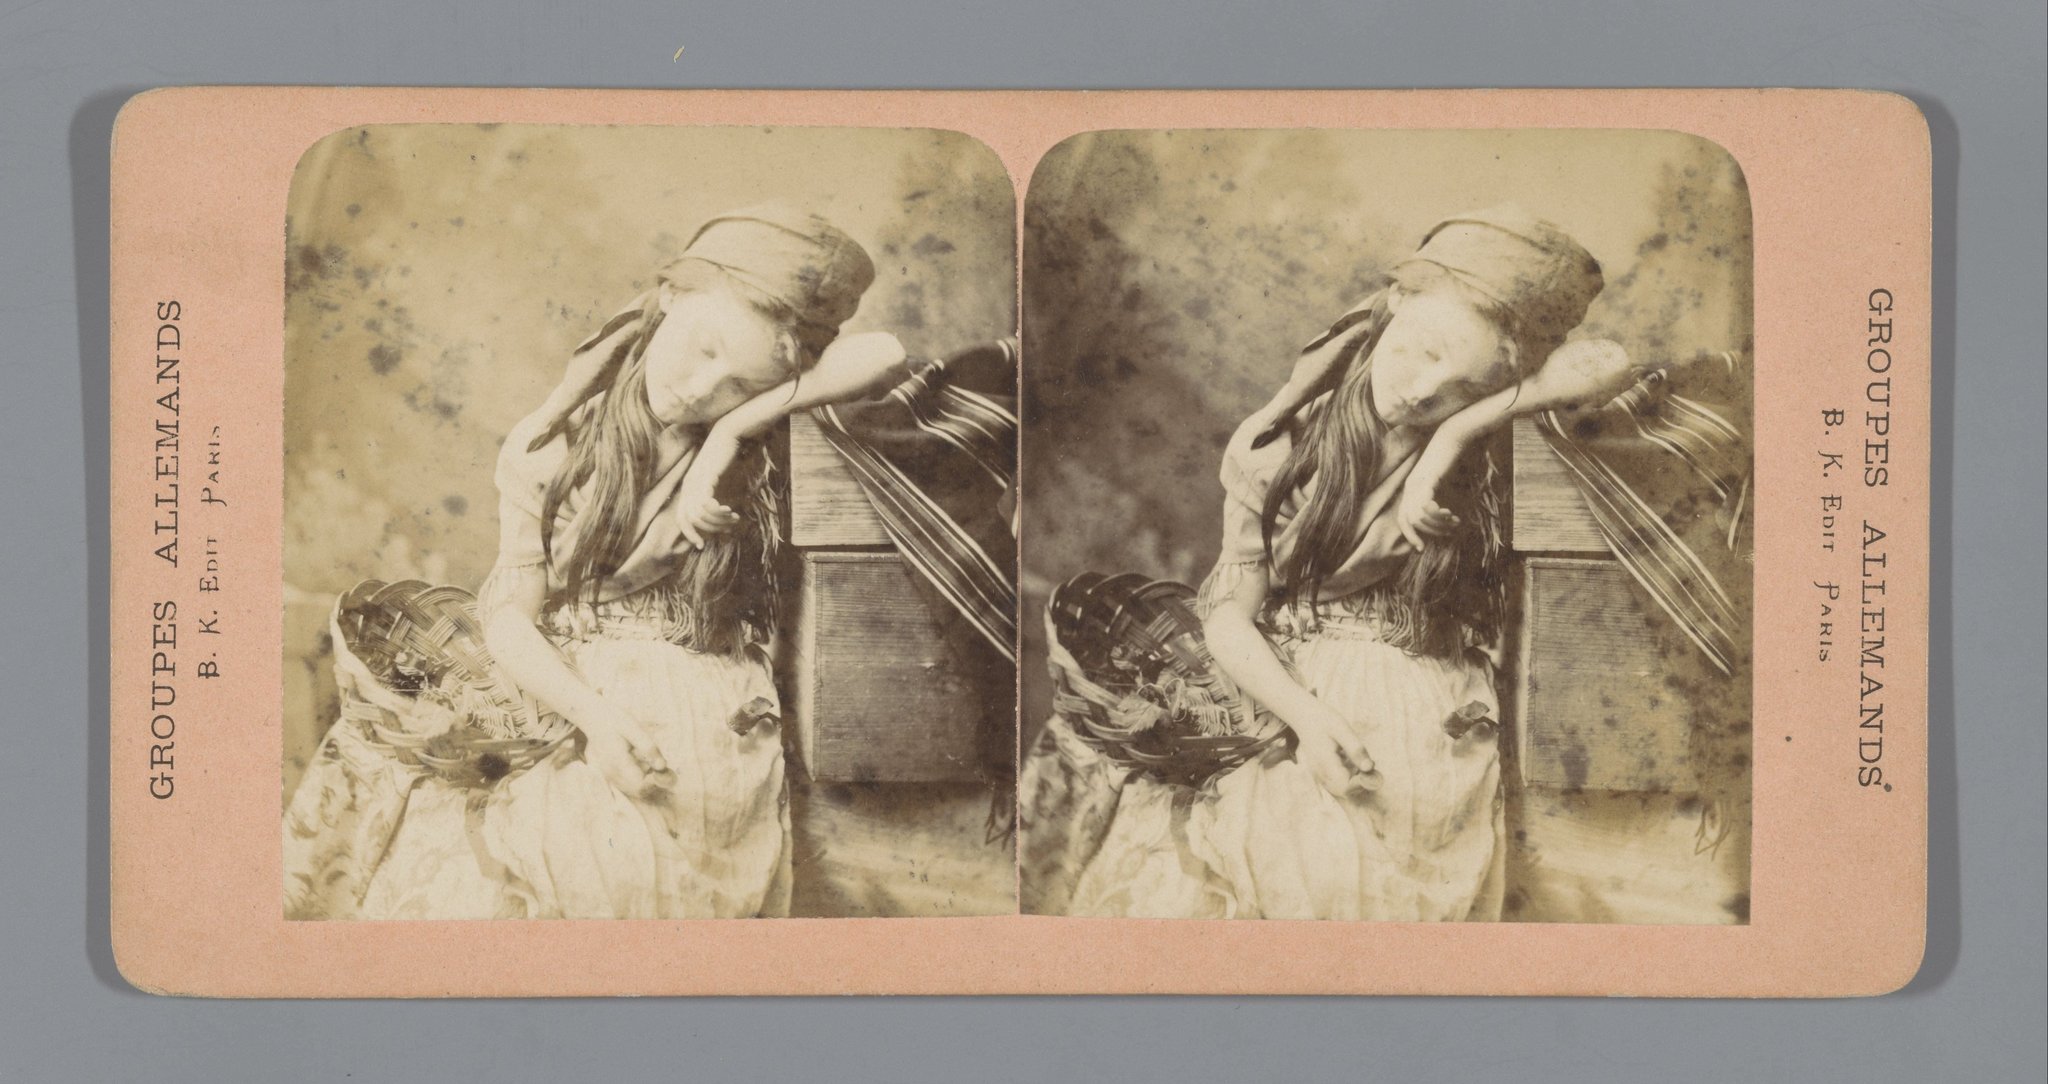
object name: stereograph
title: Groupes allemands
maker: adolphe block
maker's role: publisher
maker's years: 1829-1918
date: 1855-1875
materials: cardboard, photographic support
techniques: albumen print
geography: paris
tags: sleeping; unconsciousness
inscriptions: number: ‘45’